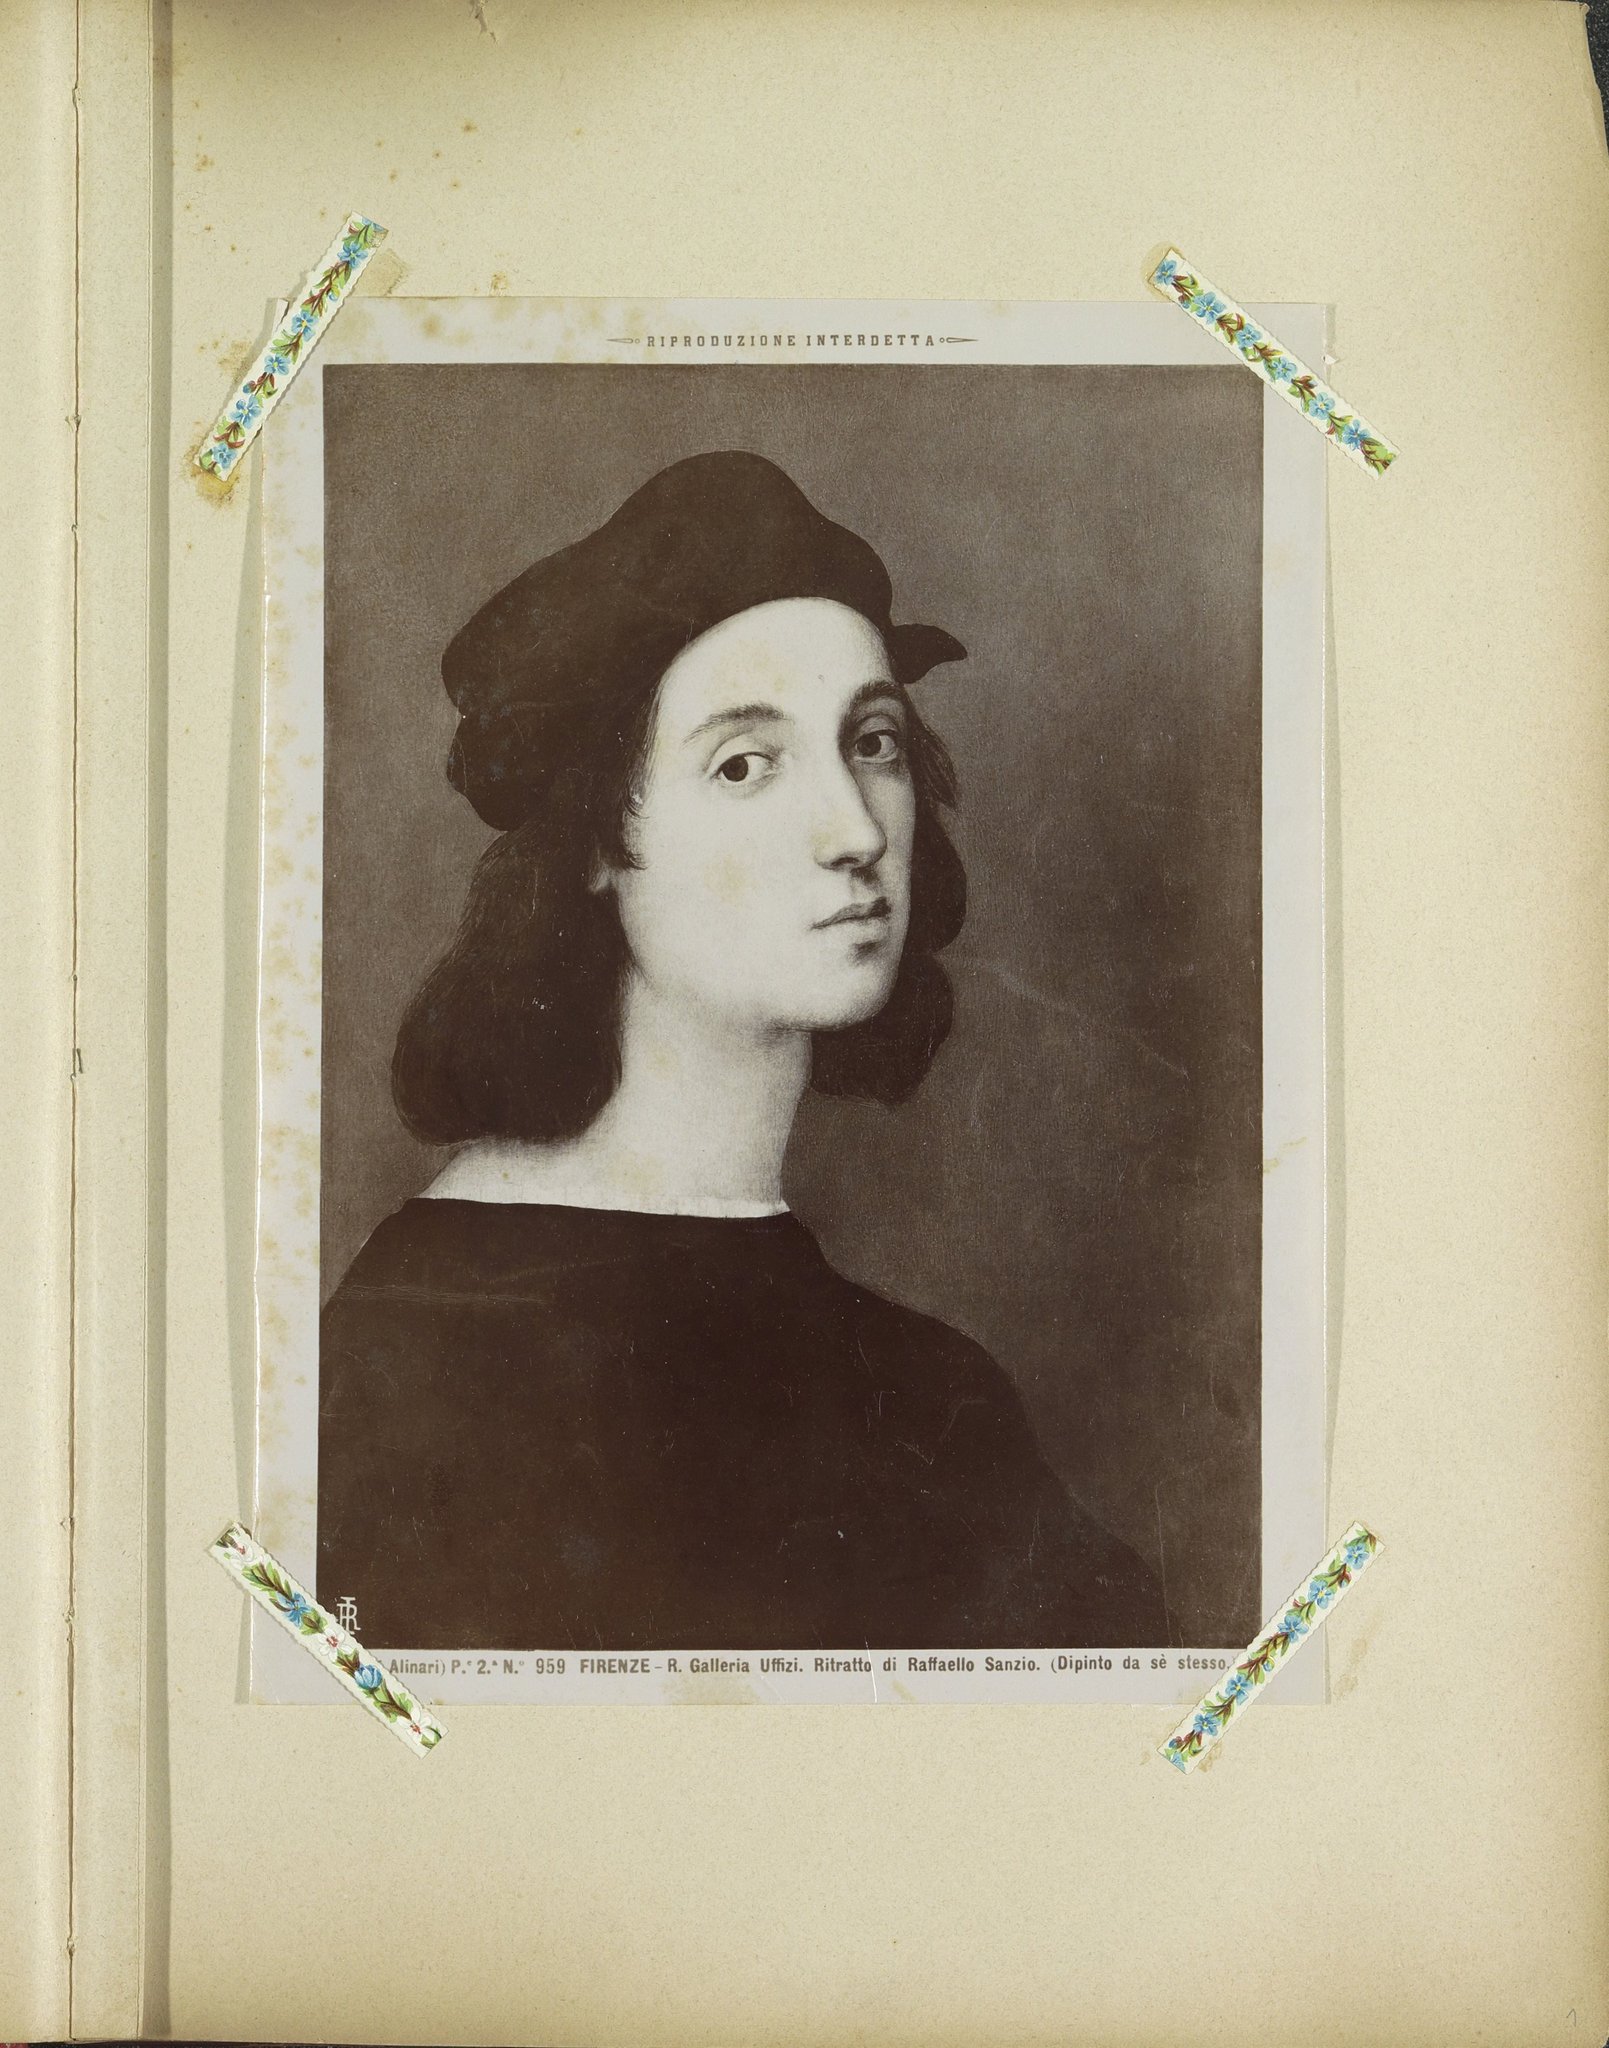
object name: photograph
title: Fotoreproductie van een zelfportret van Rafaël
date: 1860-1900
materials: photographic support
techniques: albumen print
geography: florence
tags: rome, painter, rafaël, portrait, self-portrait of artist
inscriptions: number: ‘P.e.2a. No. 959’, inscription: ‘IR’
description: Onderdeel van Fotoalbum met opnames van bezienswaardigheden in Italiaanse steden en van kunstwerken.